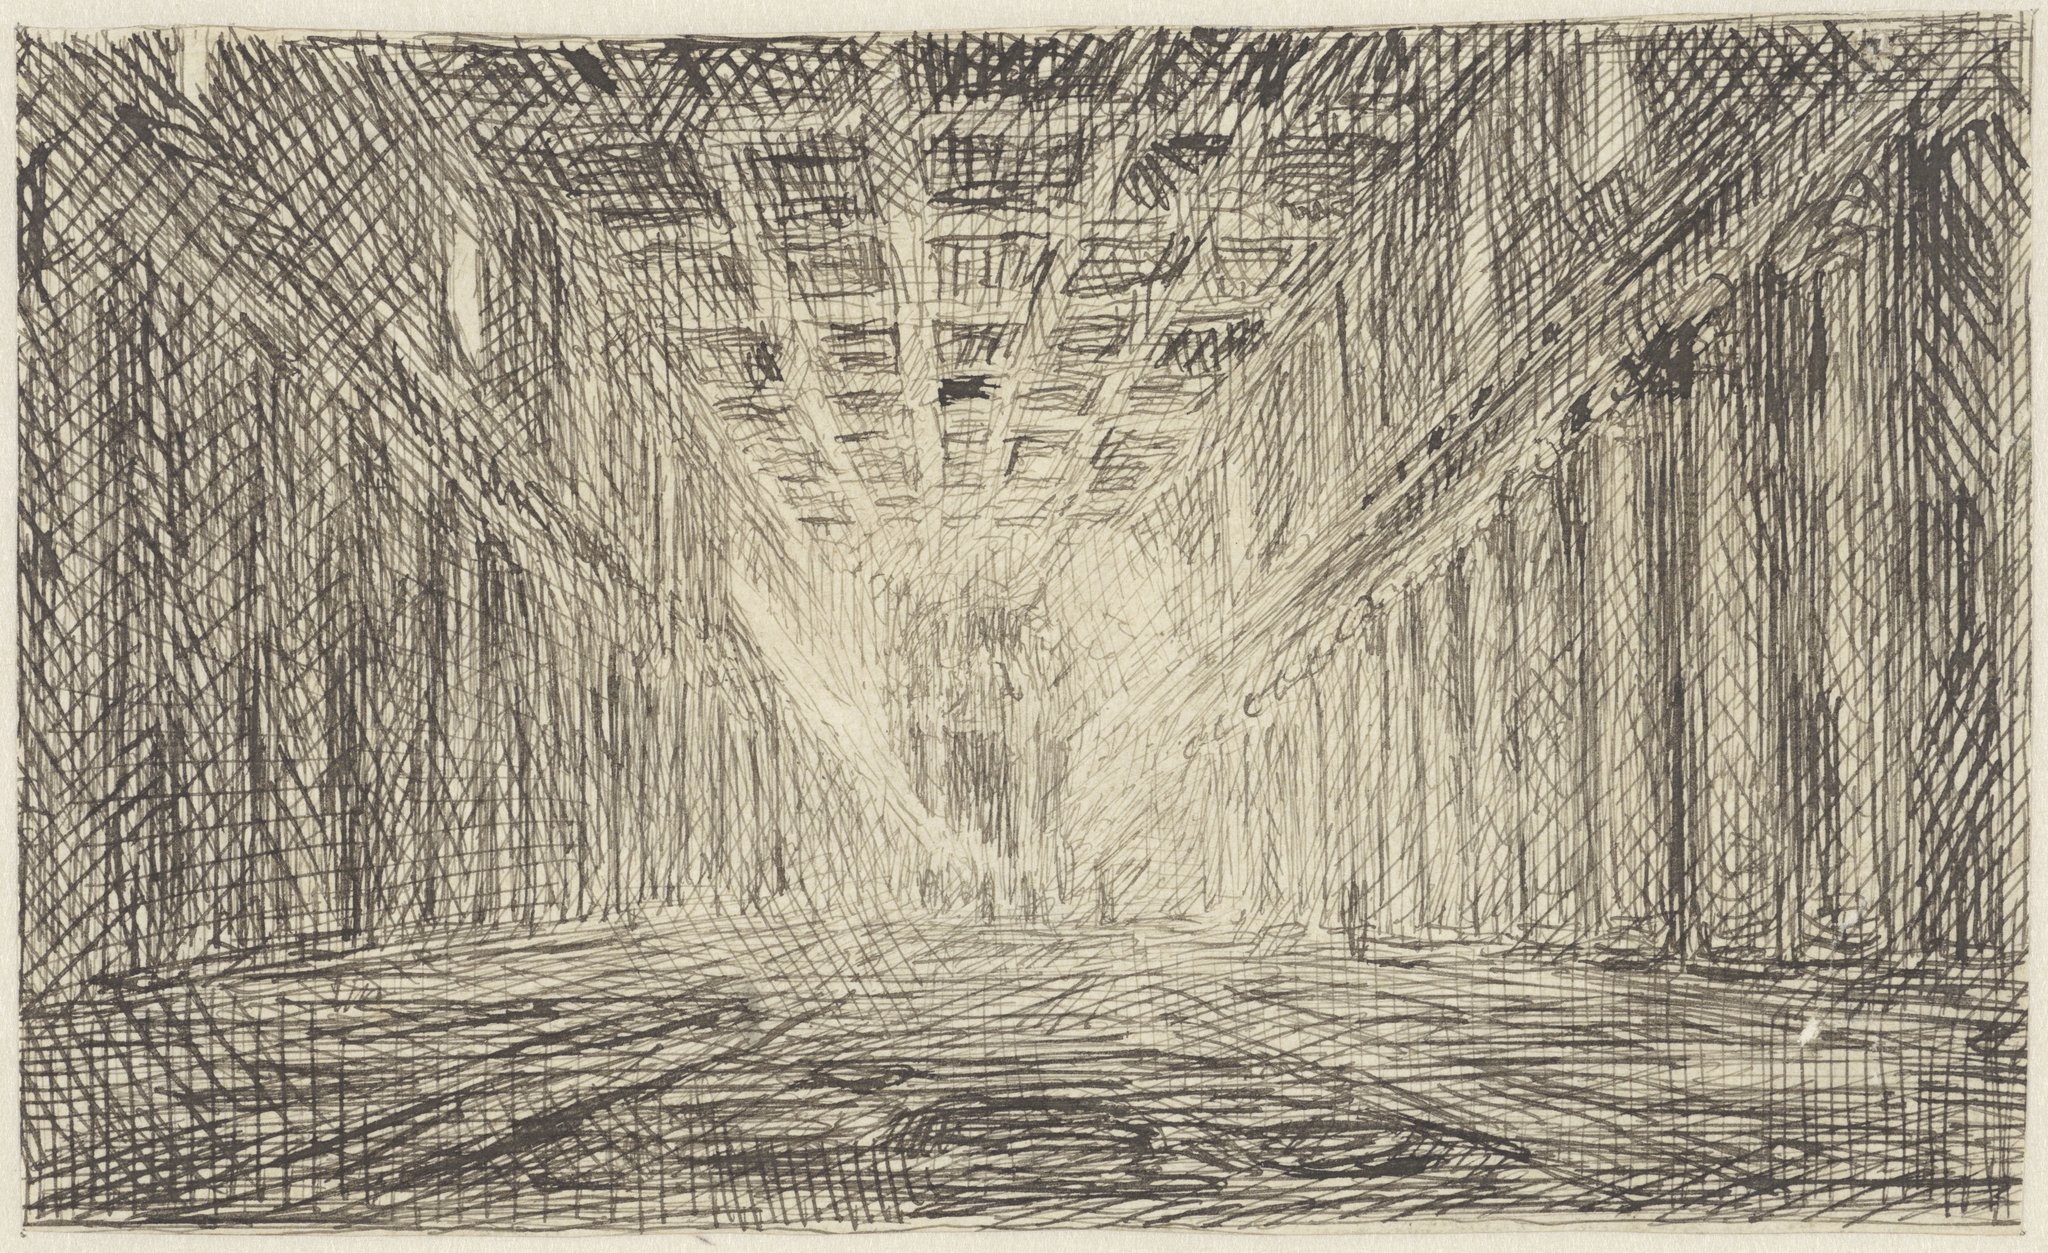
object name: drawing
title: Interieur van de Santa Maria Maggiore te Rome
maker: thomas cool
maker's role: draughtsman, painter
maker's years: 1851-1904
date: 1861-1904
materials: ink, paper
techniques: pen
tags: interior of church, italy, rome